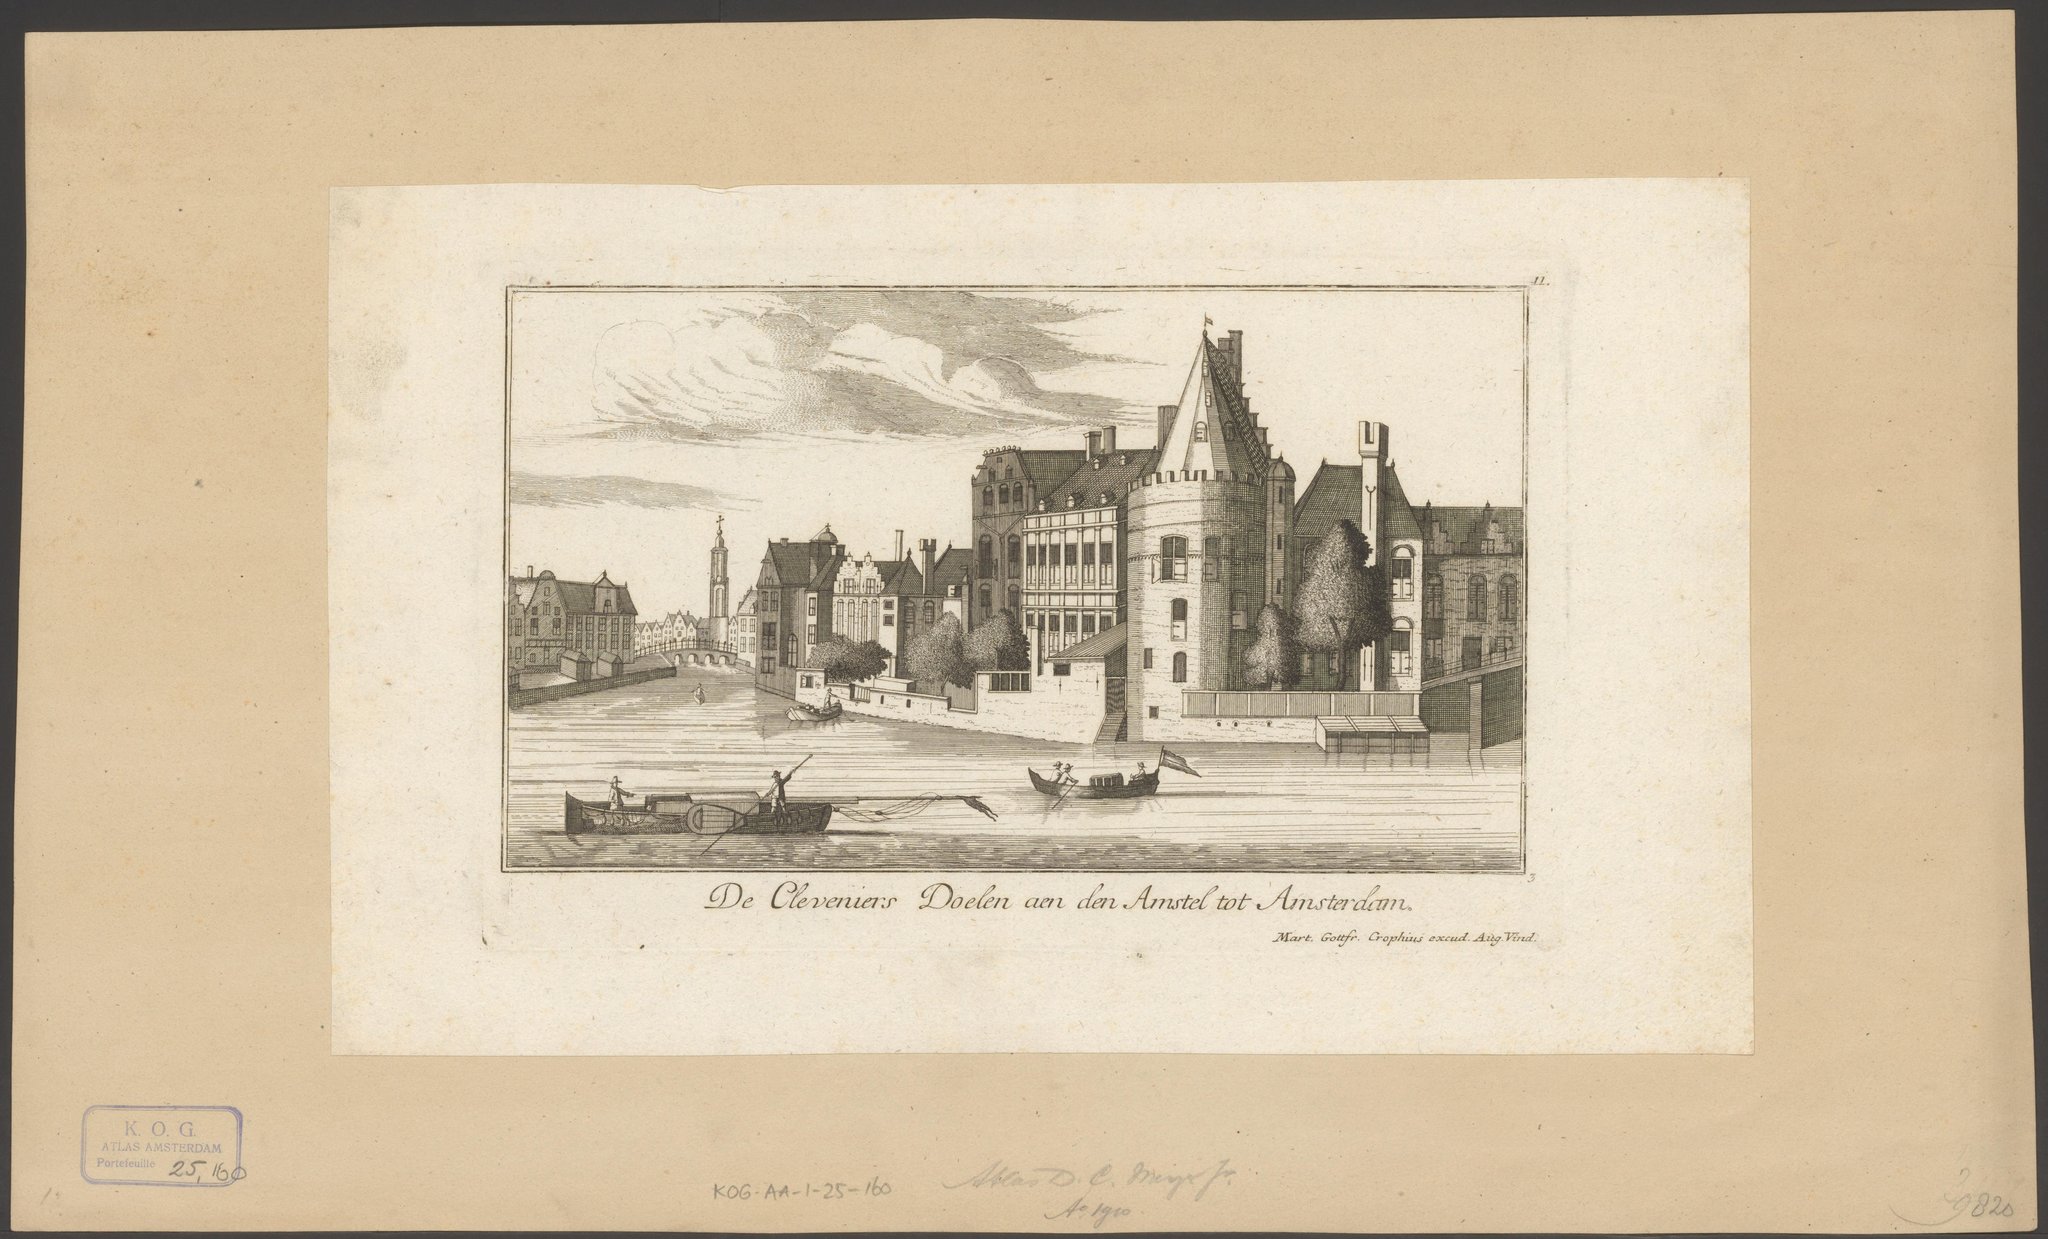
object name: print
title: Gezicht op de Kloveniersdoelen te Amsterdam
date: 1737-1765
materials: paper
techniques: etching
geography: augsburg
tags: towers ~ fortified city, rowing-boat, canoe, etc., land forces (+ citizen soldiery, civil guard, citizen militia), canals, waters (in city) (+ city(-scape) with figures, staffage)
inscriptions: collector's mark: ‘25.160’ Lugt 1641b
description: Genummerd rechtsboven: 11, genummerd rechtsonder: 3. Onderwerpsrubriek binnen de Atlas Amsterdam: Krijgswezen I: De Admiraliteit van Amsterdam, E. Doelen en Wachthuizen.